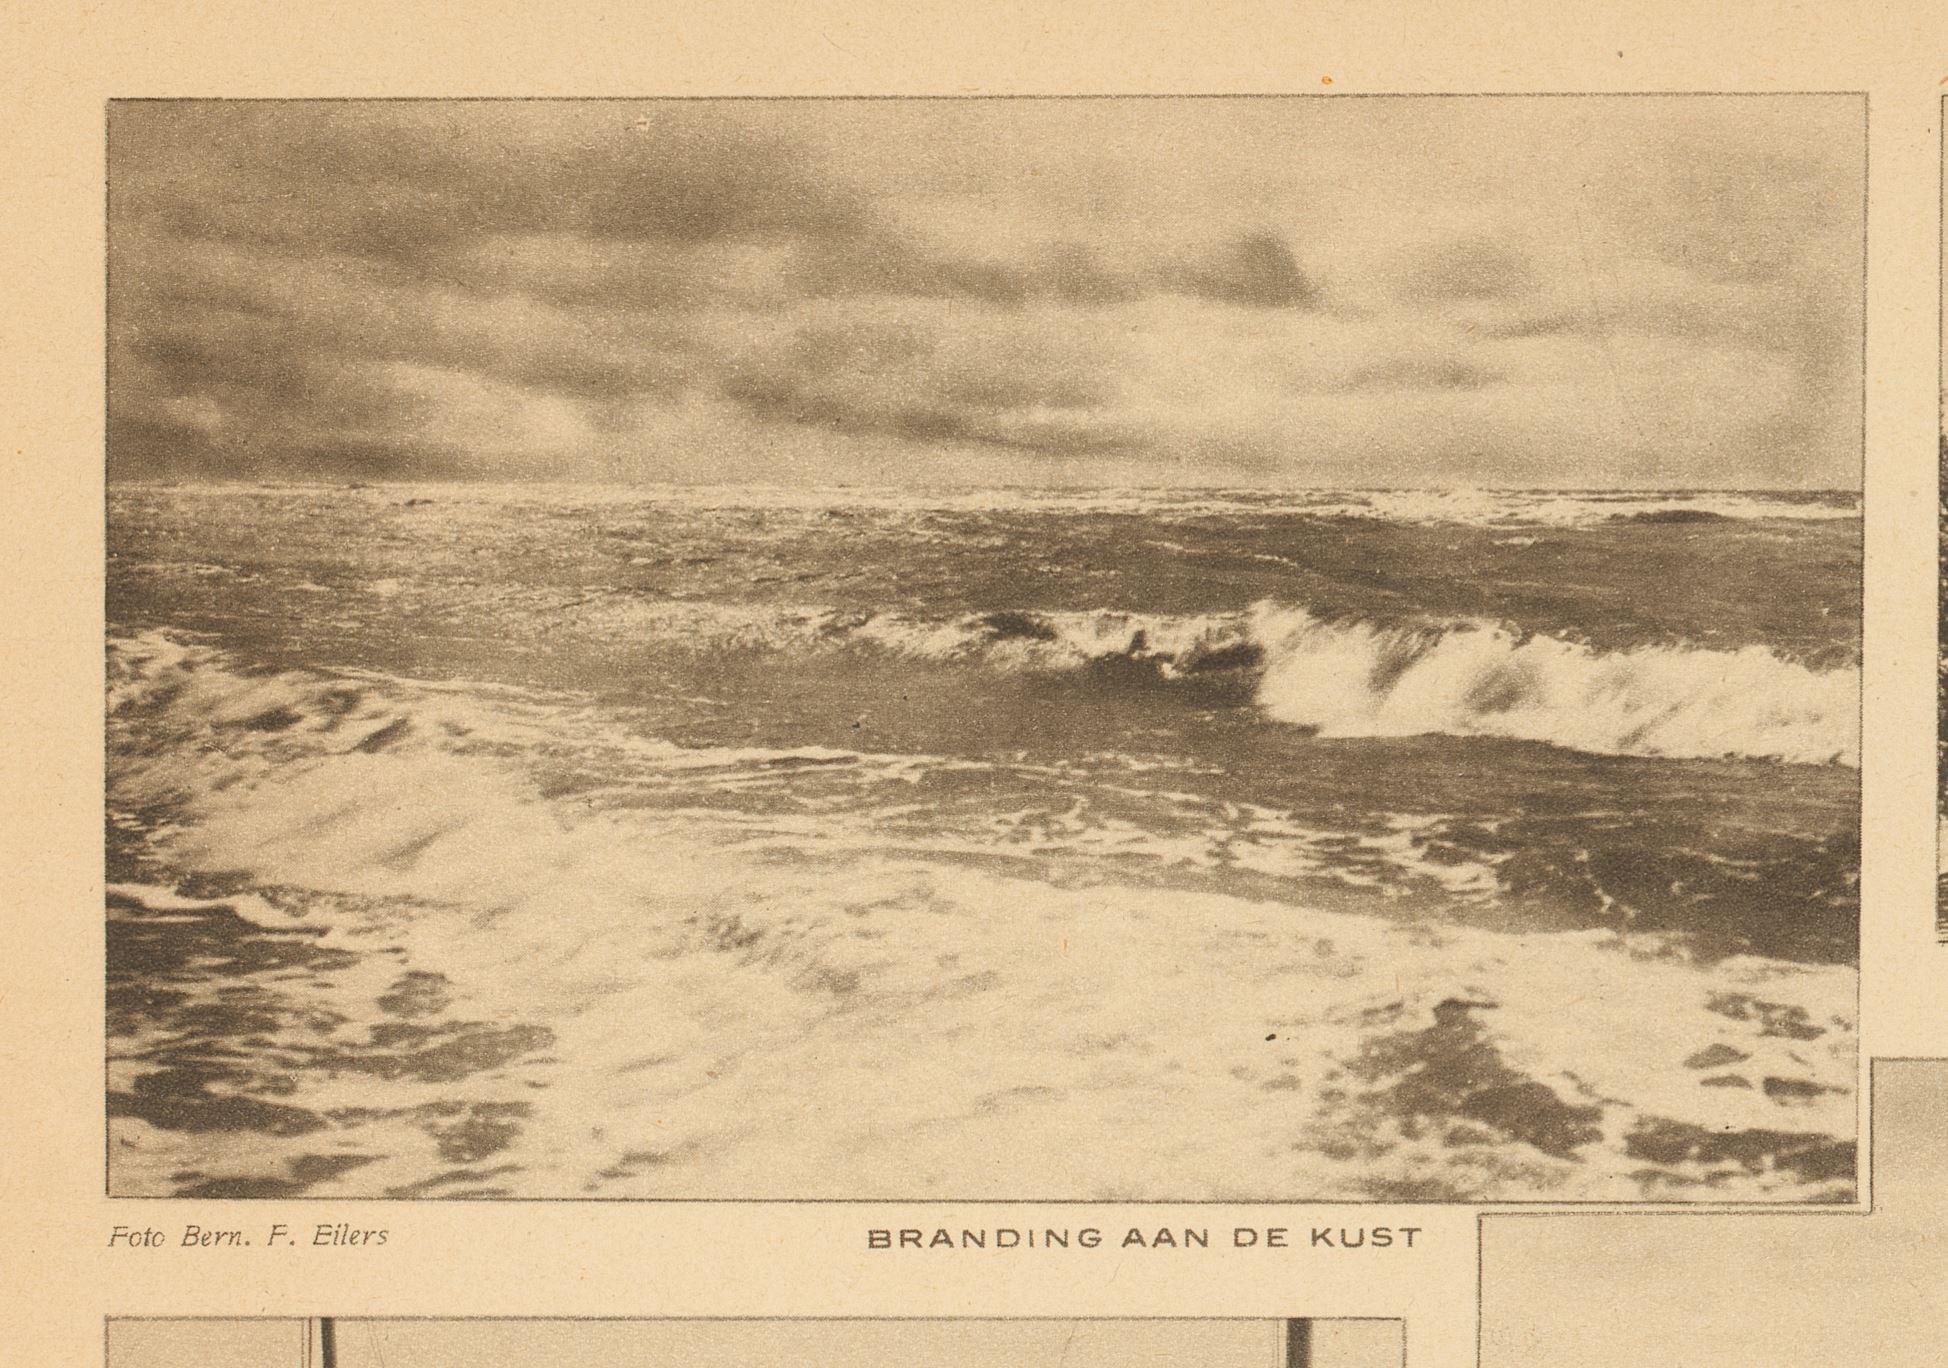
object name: photomechanical print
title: Gezicht op de branding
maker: bernard eilers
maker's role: fotograaf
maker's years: 1878-1951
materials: paper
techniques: rotogravure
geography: leiden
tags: surf, breakers, netherlands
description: Deze prent maakt deel uit van een album.